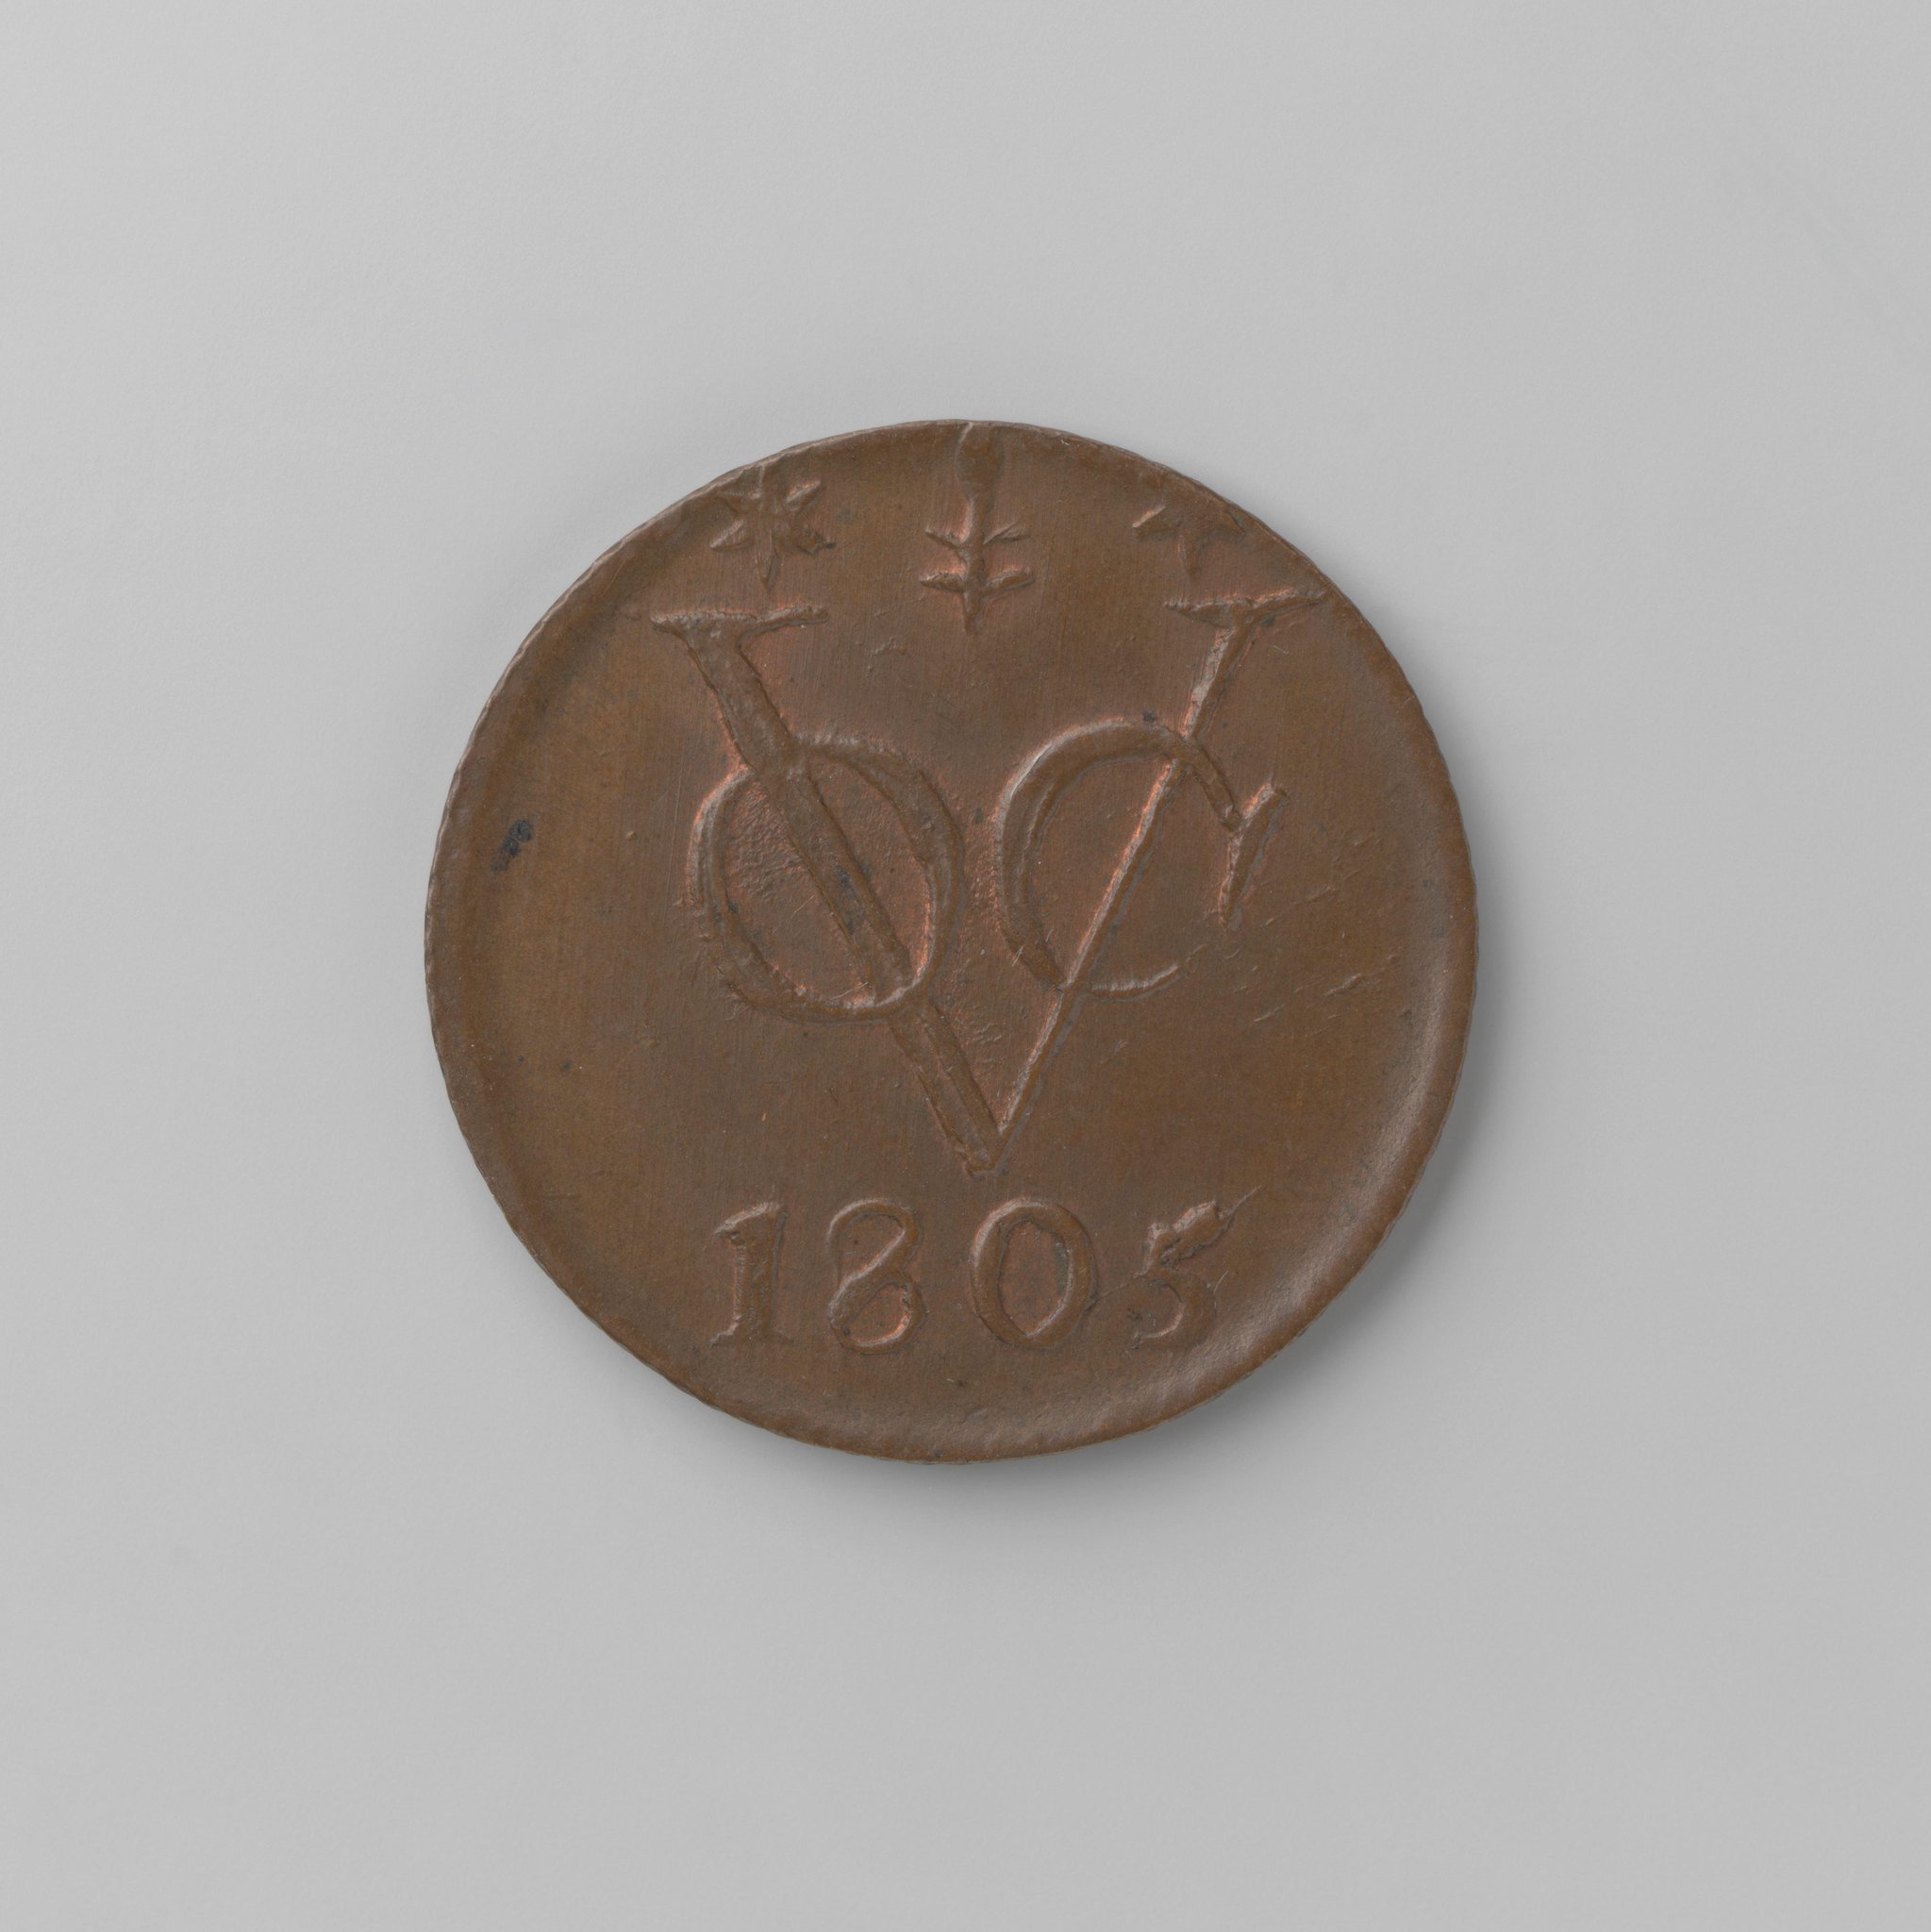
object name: coin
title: Duit voor Nederlands Indië uit Gelderland,1805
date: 1805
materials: copper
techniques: striking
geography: harderwijk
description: Koperen munt. Voorzijde: tussen wapenspreuk gekroond wapenschild van Gelderland. Keerzijde: monogram van de VOC, waarboven muntmeesterteken en waaronder jaartal. Kabelrand.